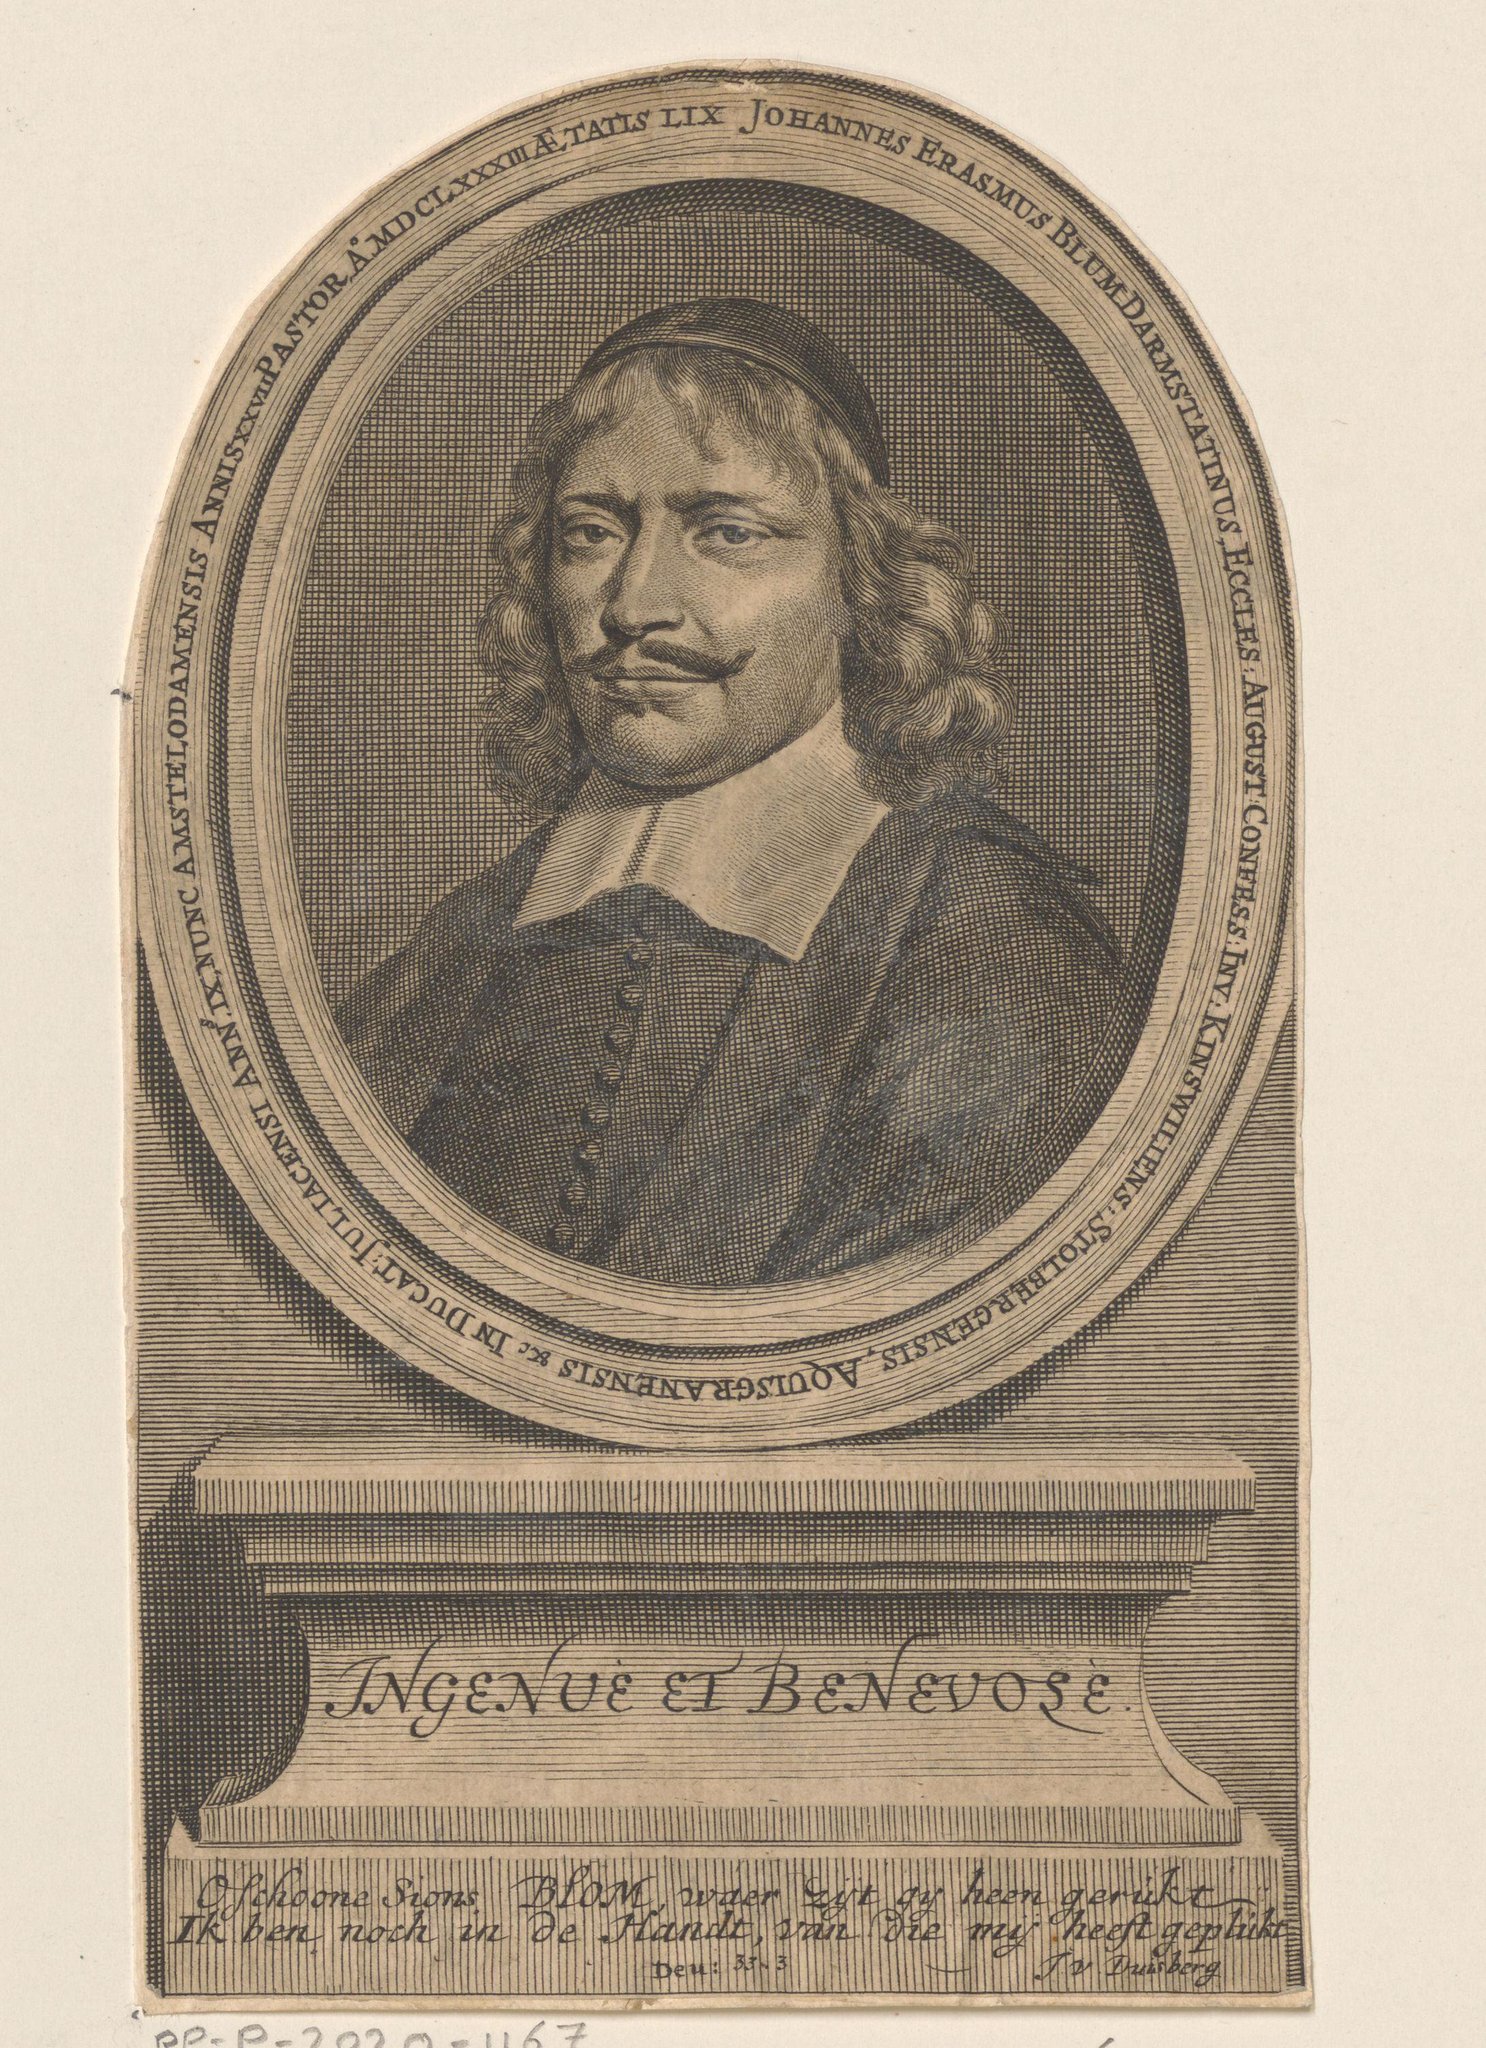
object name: print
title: Johannes Erasmus Blum Darmstatinus (...)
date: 1674-1692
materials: paper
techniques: engraving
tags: amsterdam, theologian, historical persons